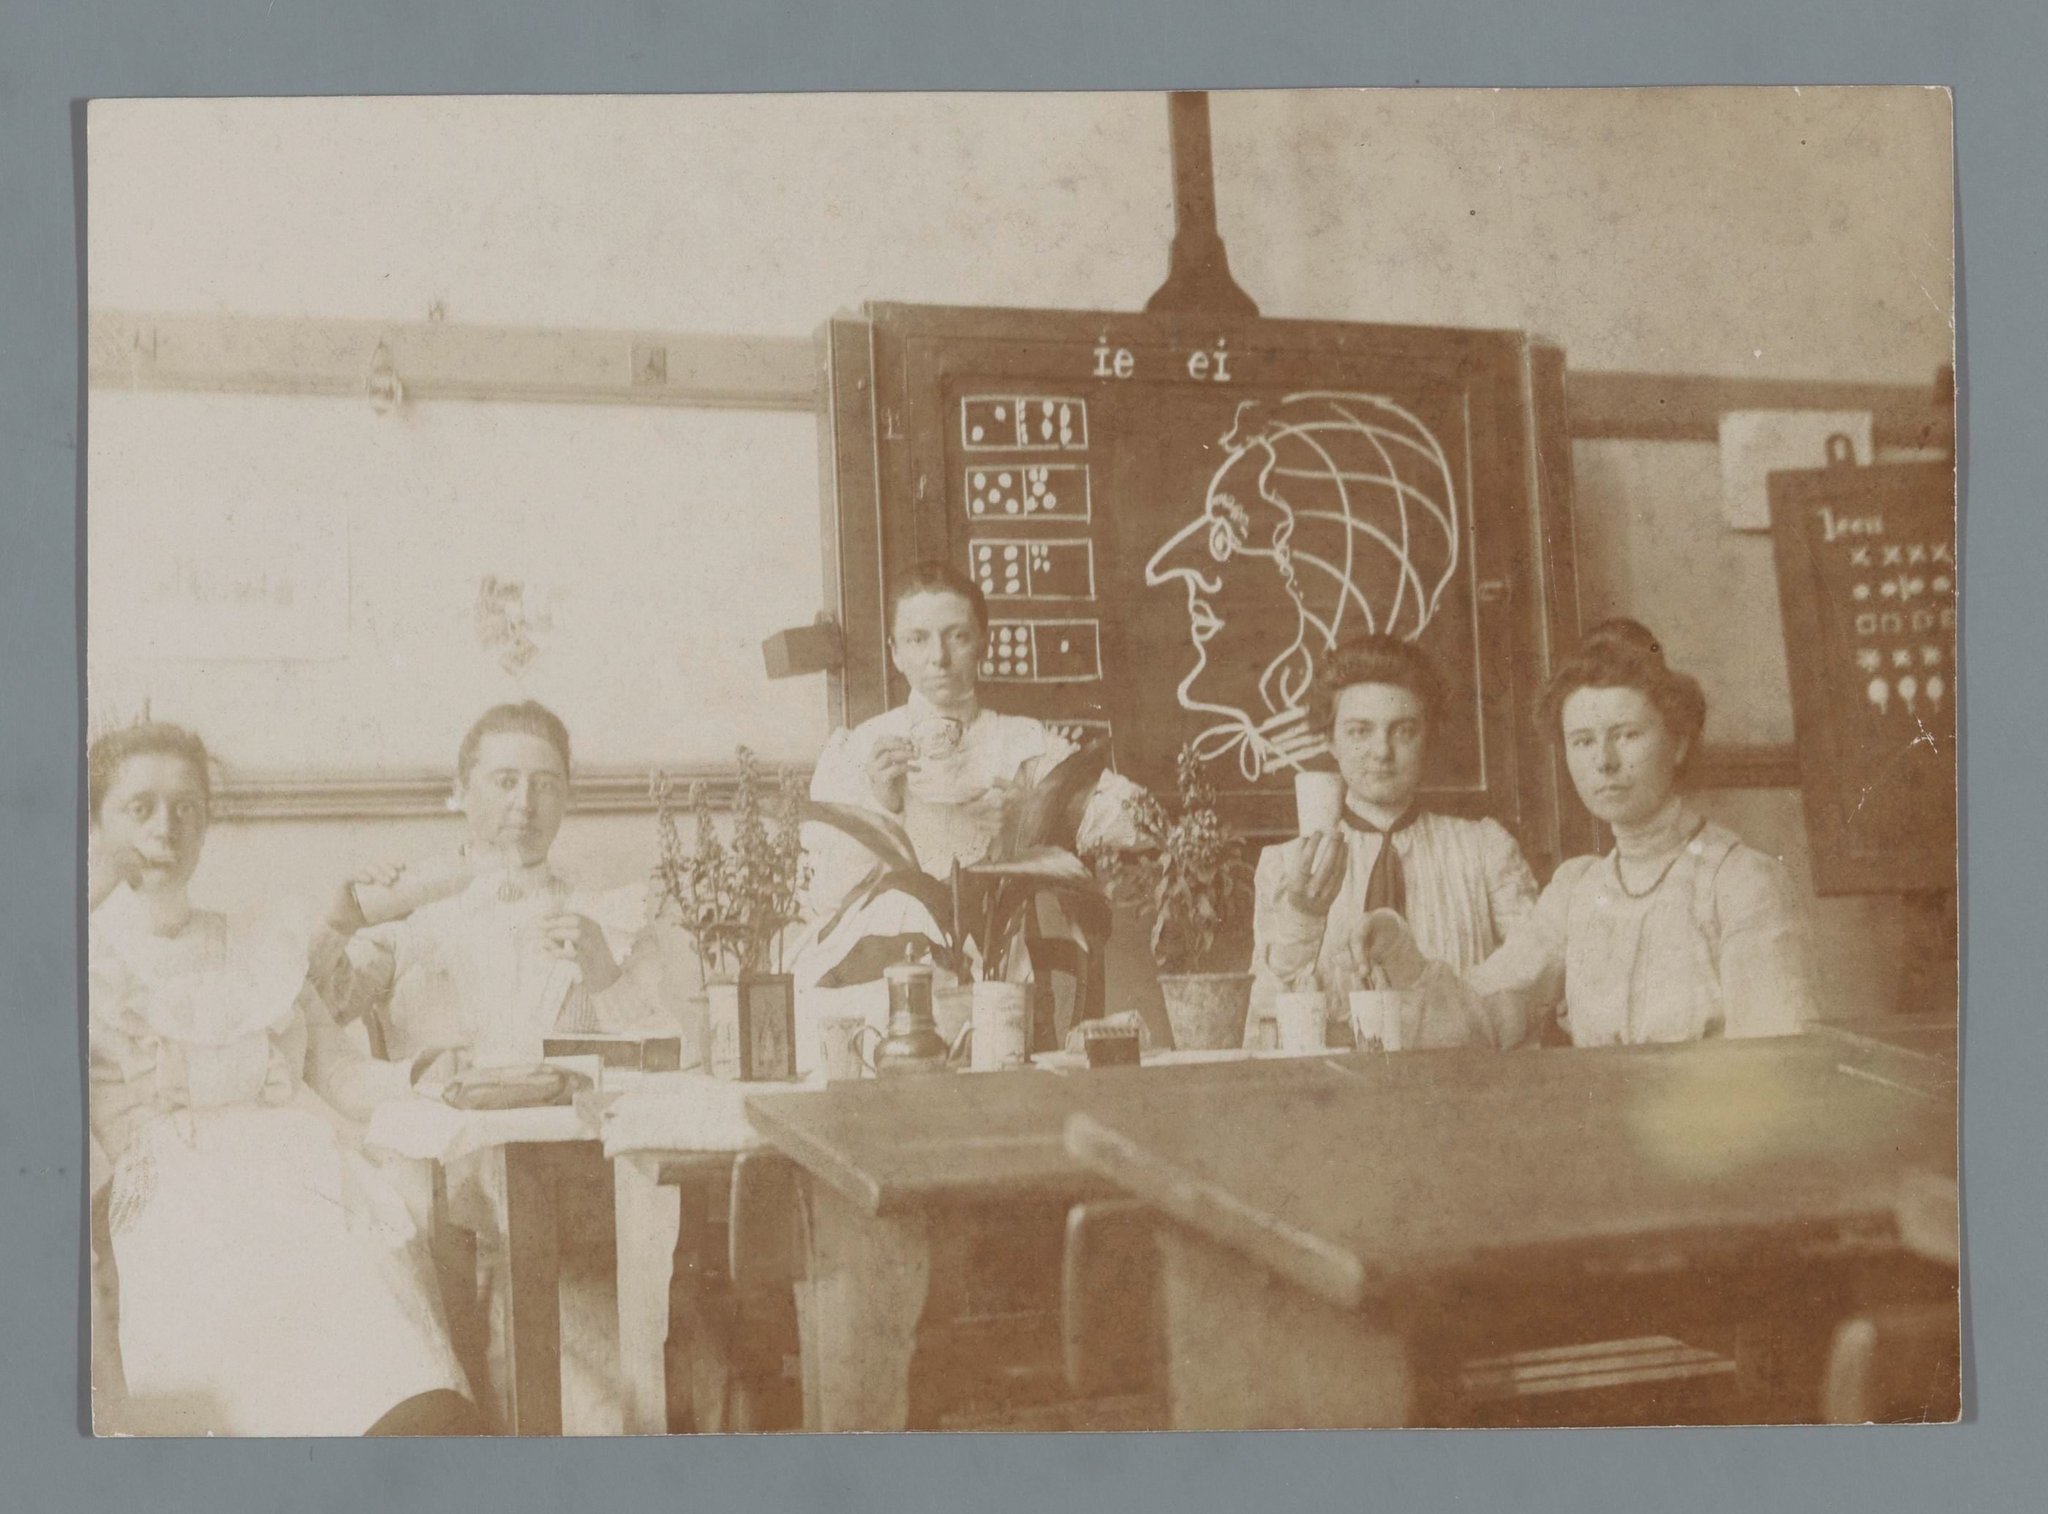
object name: photograph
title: Portret van vijf onderwijzeressen in een klaslokaal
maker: Anonymous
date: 1900-1915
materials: photographic support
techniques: collodion silver print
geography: netherlands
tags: teacher and pupil, elementary school; class, form